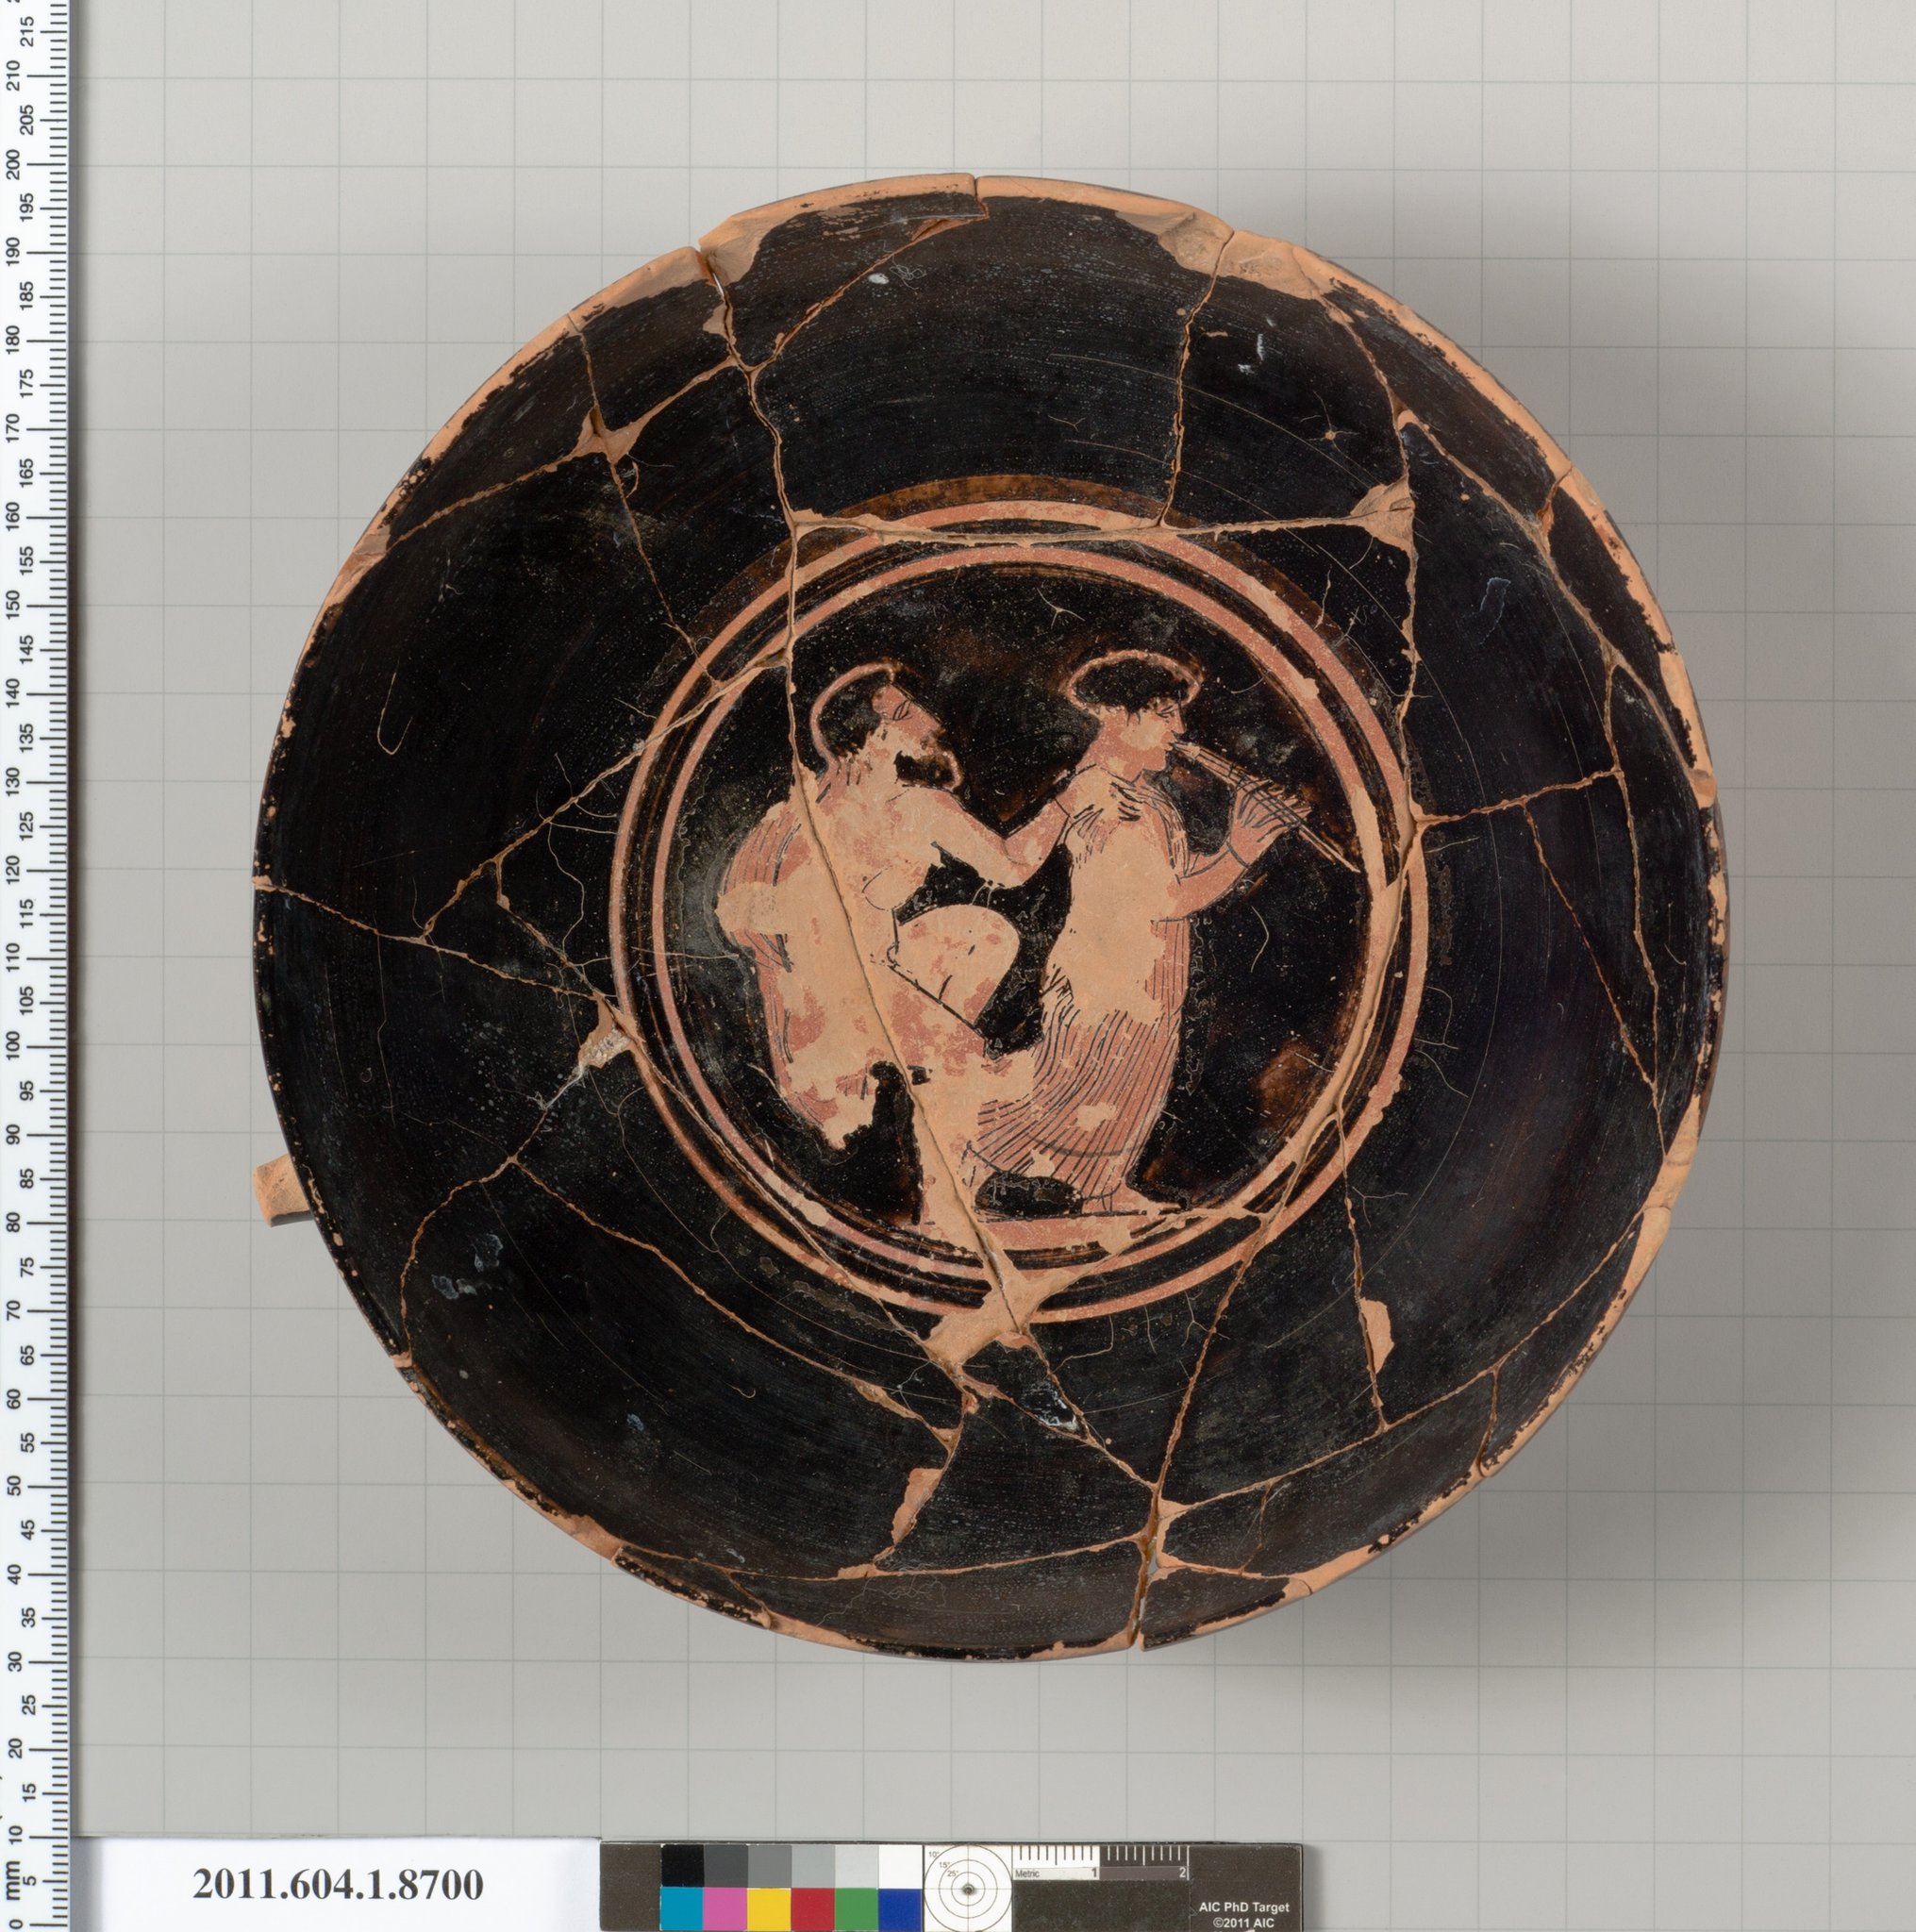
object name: kylix fragment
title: Terracotta stemless kylix (drinking cup)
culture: greek, attic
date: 430-420 BCE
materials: terracotta